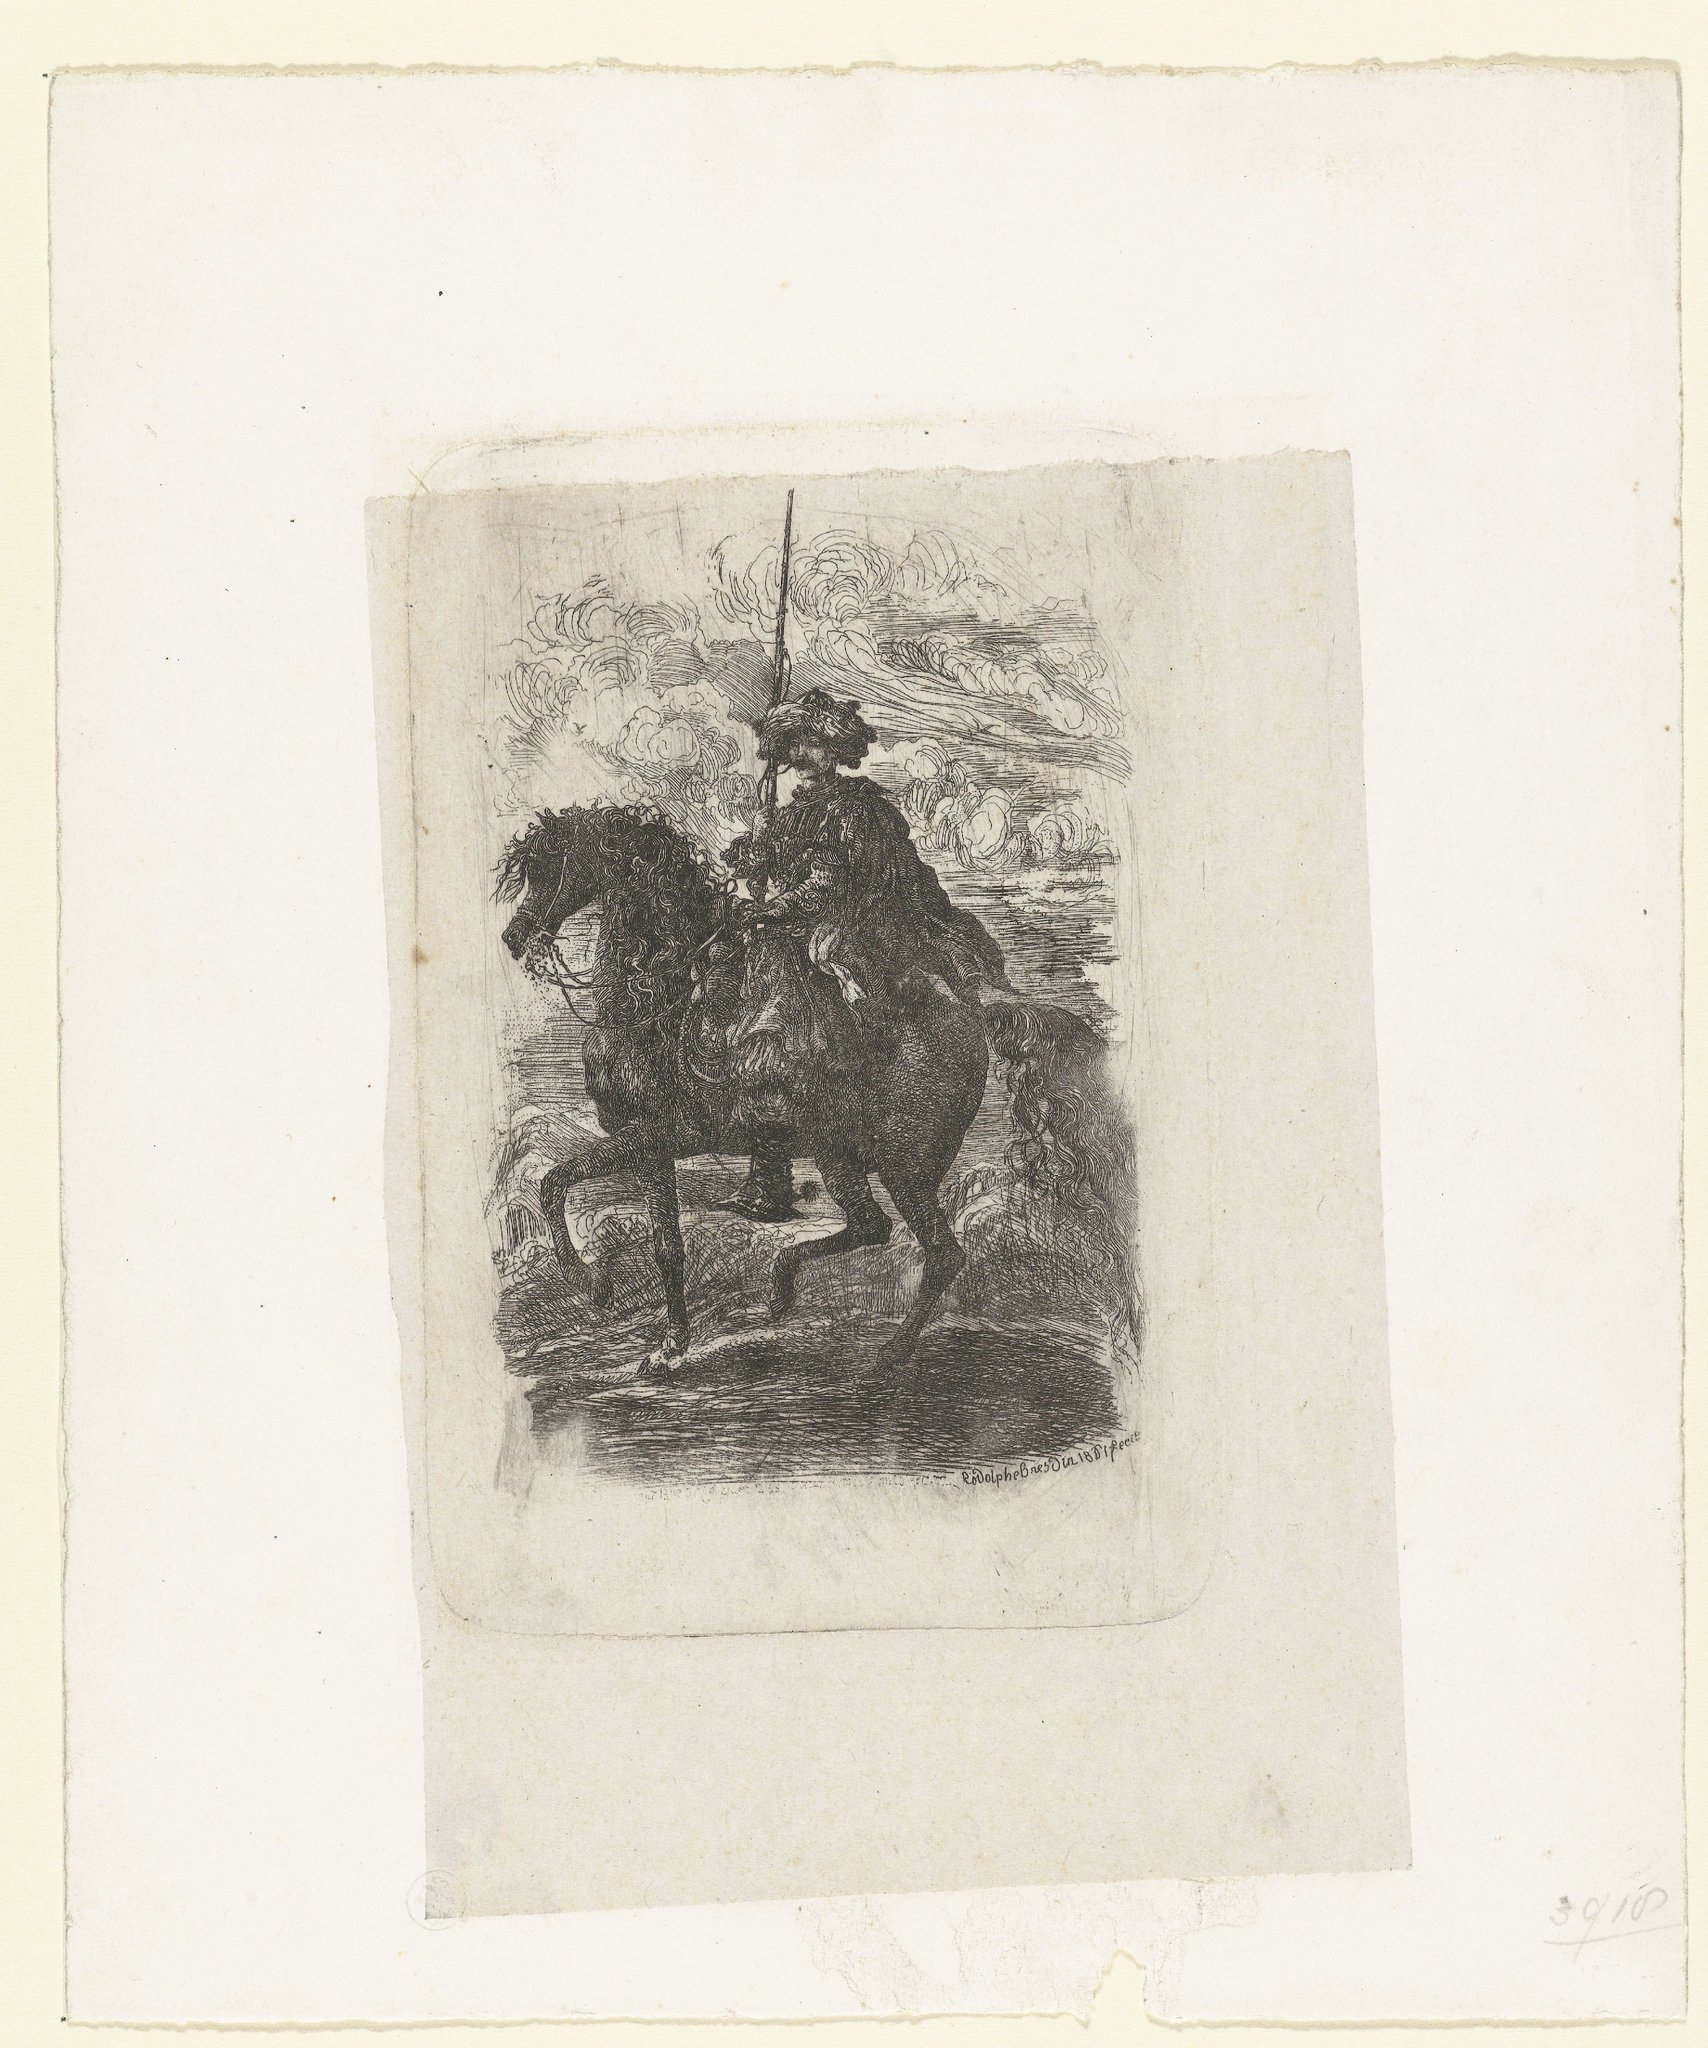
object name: print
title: Cavalier oriental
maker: rodolphe bresdin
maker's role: draughtsman, print maker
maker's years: 1822-1885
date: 1861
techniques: printmaking, etching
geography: bordeaux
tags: riding a horse, ass, or mule; rider, horseman, asiatic races and peoples, private soldier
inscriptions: collector's mark: Lugt 2228, collector's mark: Lugt 733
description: Man in oosterse kleding te paard houdt een karabijngeweer vast. Op zijn hoofd draagt hij een tulband. Het paard met lange krullende manen en staart loopt naar links in een rotsachtig landschap met een lage horizon. Het blad dun chinees papier dat de kunstenaar voor deze techniek (chine collé) gebruikte is bij deze afdruk met een etsplaat scheef op het ondersteunende stevige blad terecht gekomen.